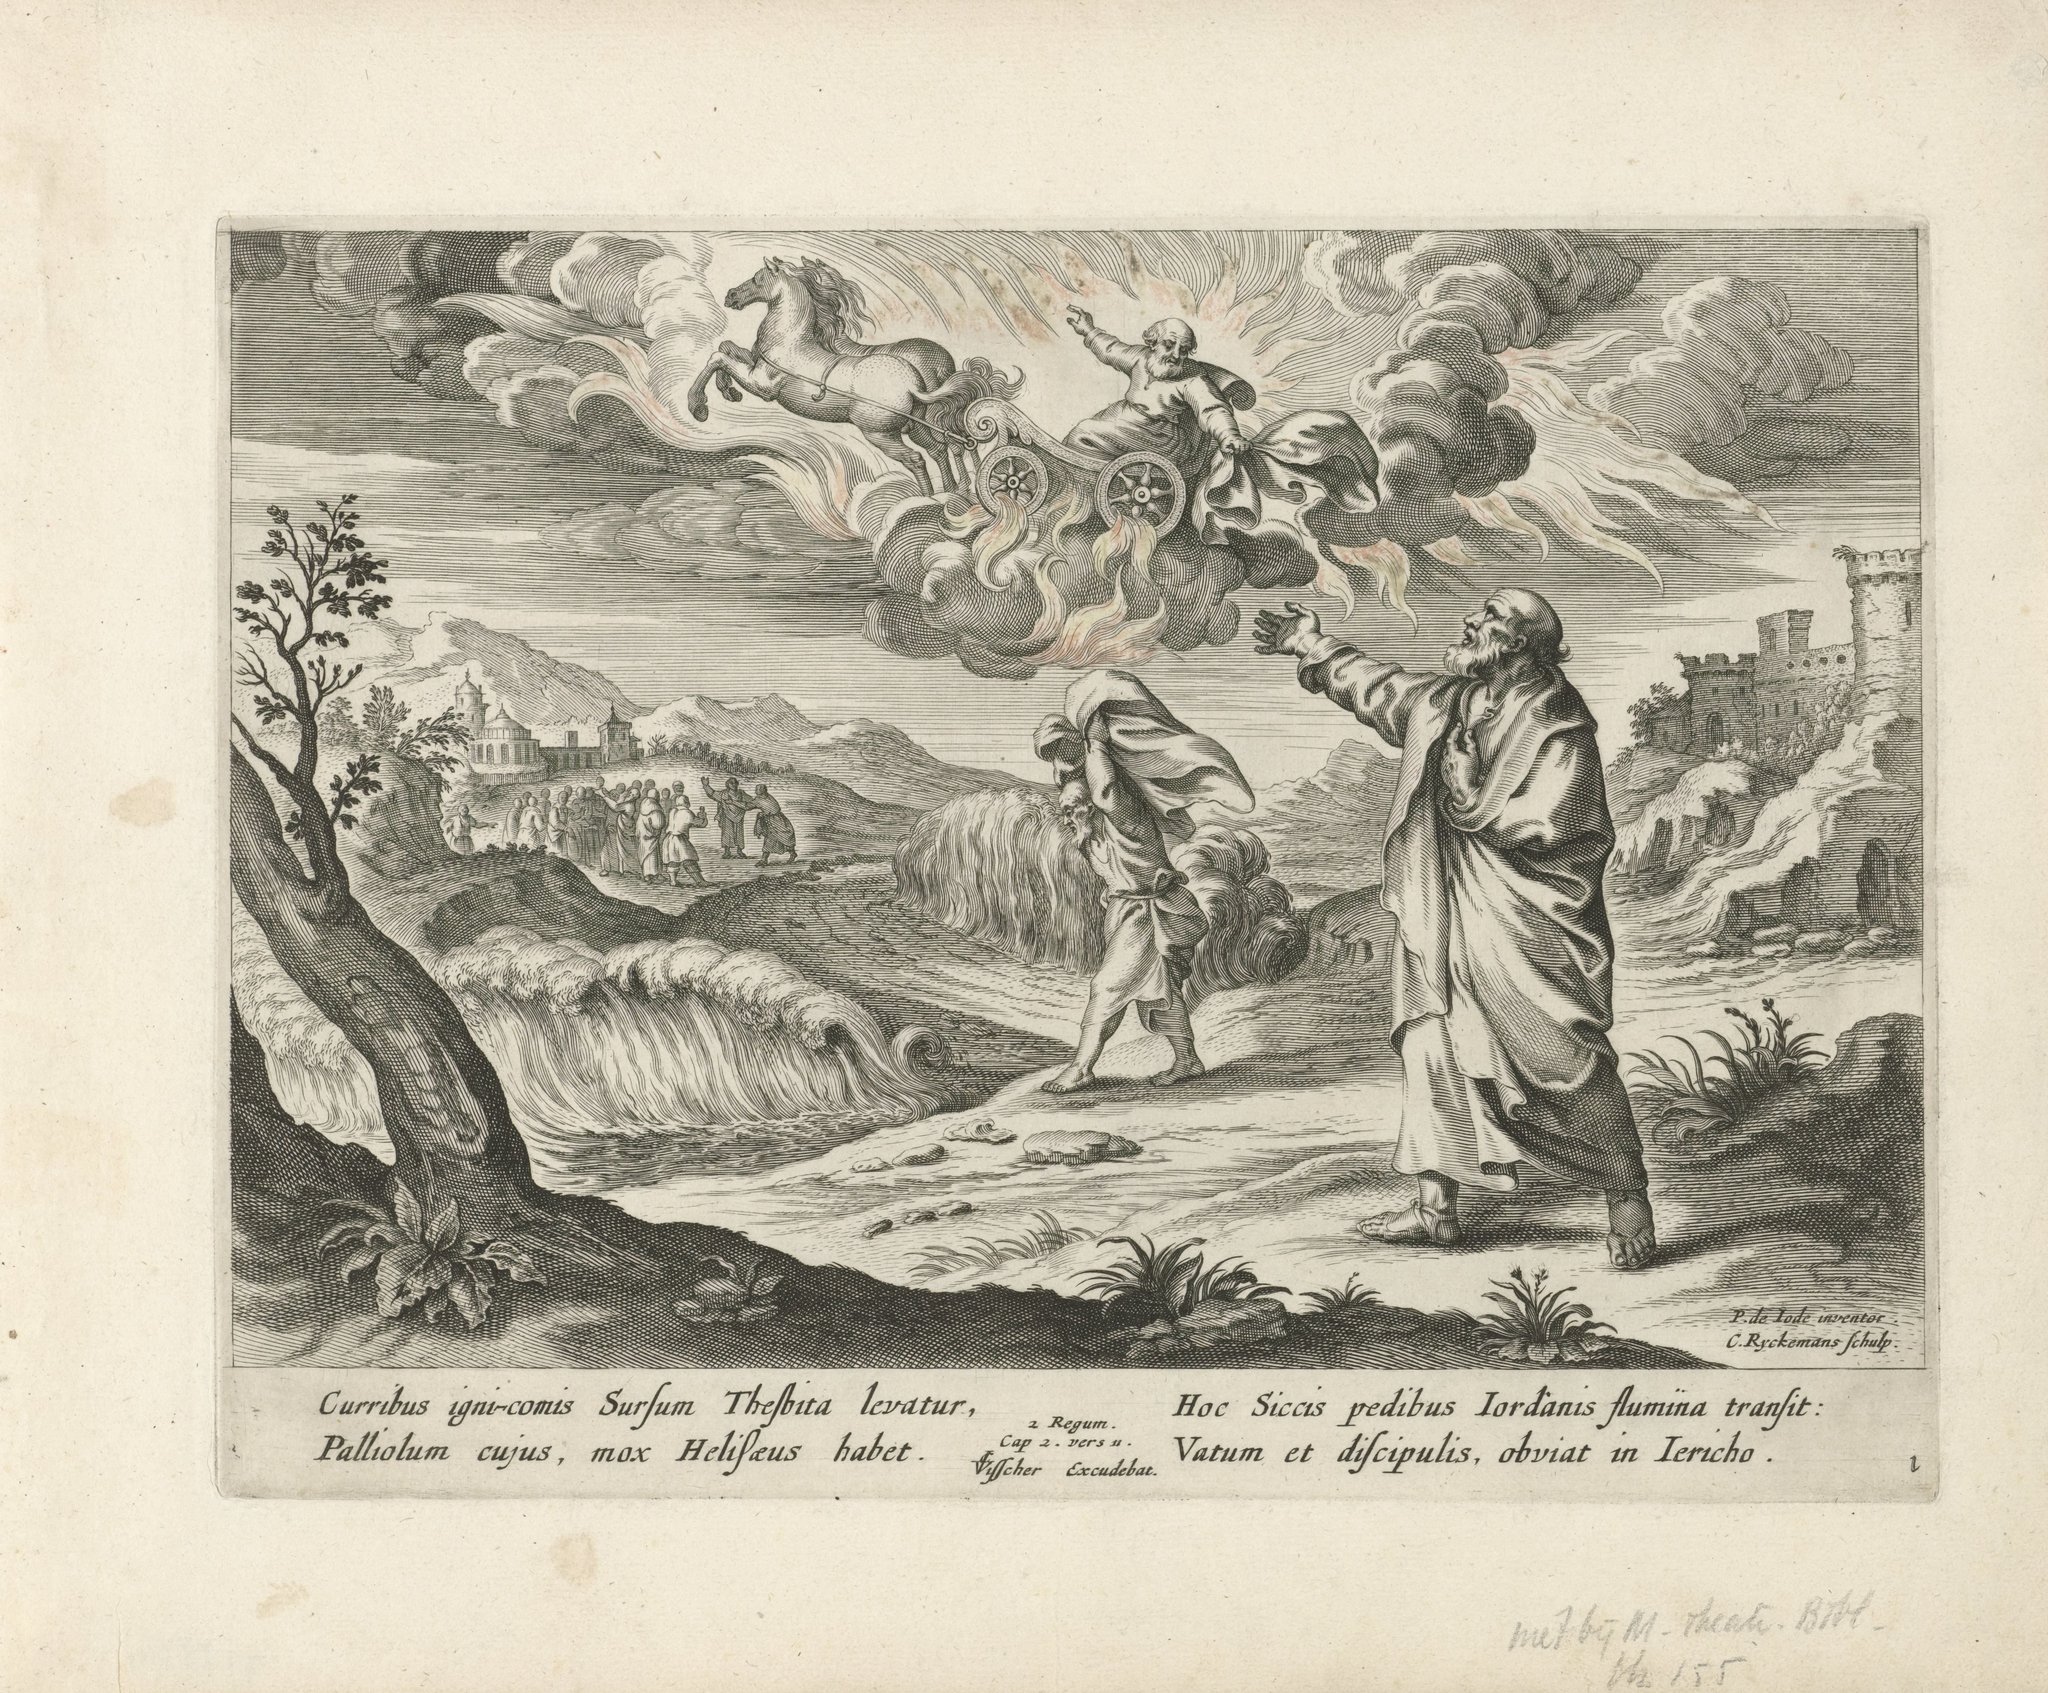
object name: print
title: Geschiedenis van Elisa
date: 1643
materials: paper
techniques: brush, engraving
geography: amsterdam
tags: a chariot, horses of fire and a whirlwind appear and elijah is carried up into heaven; elijah's cloak falls (or he hands it over to elisha)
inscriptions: collector's mark: Lugt 2228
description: De profeet Elisa ontvangt de mantel van Elia die in een vurige wagen naar de hemel rijdt. Op de achtergrond slaat Elisa het water van de Jordaan met de mantel van Elia.